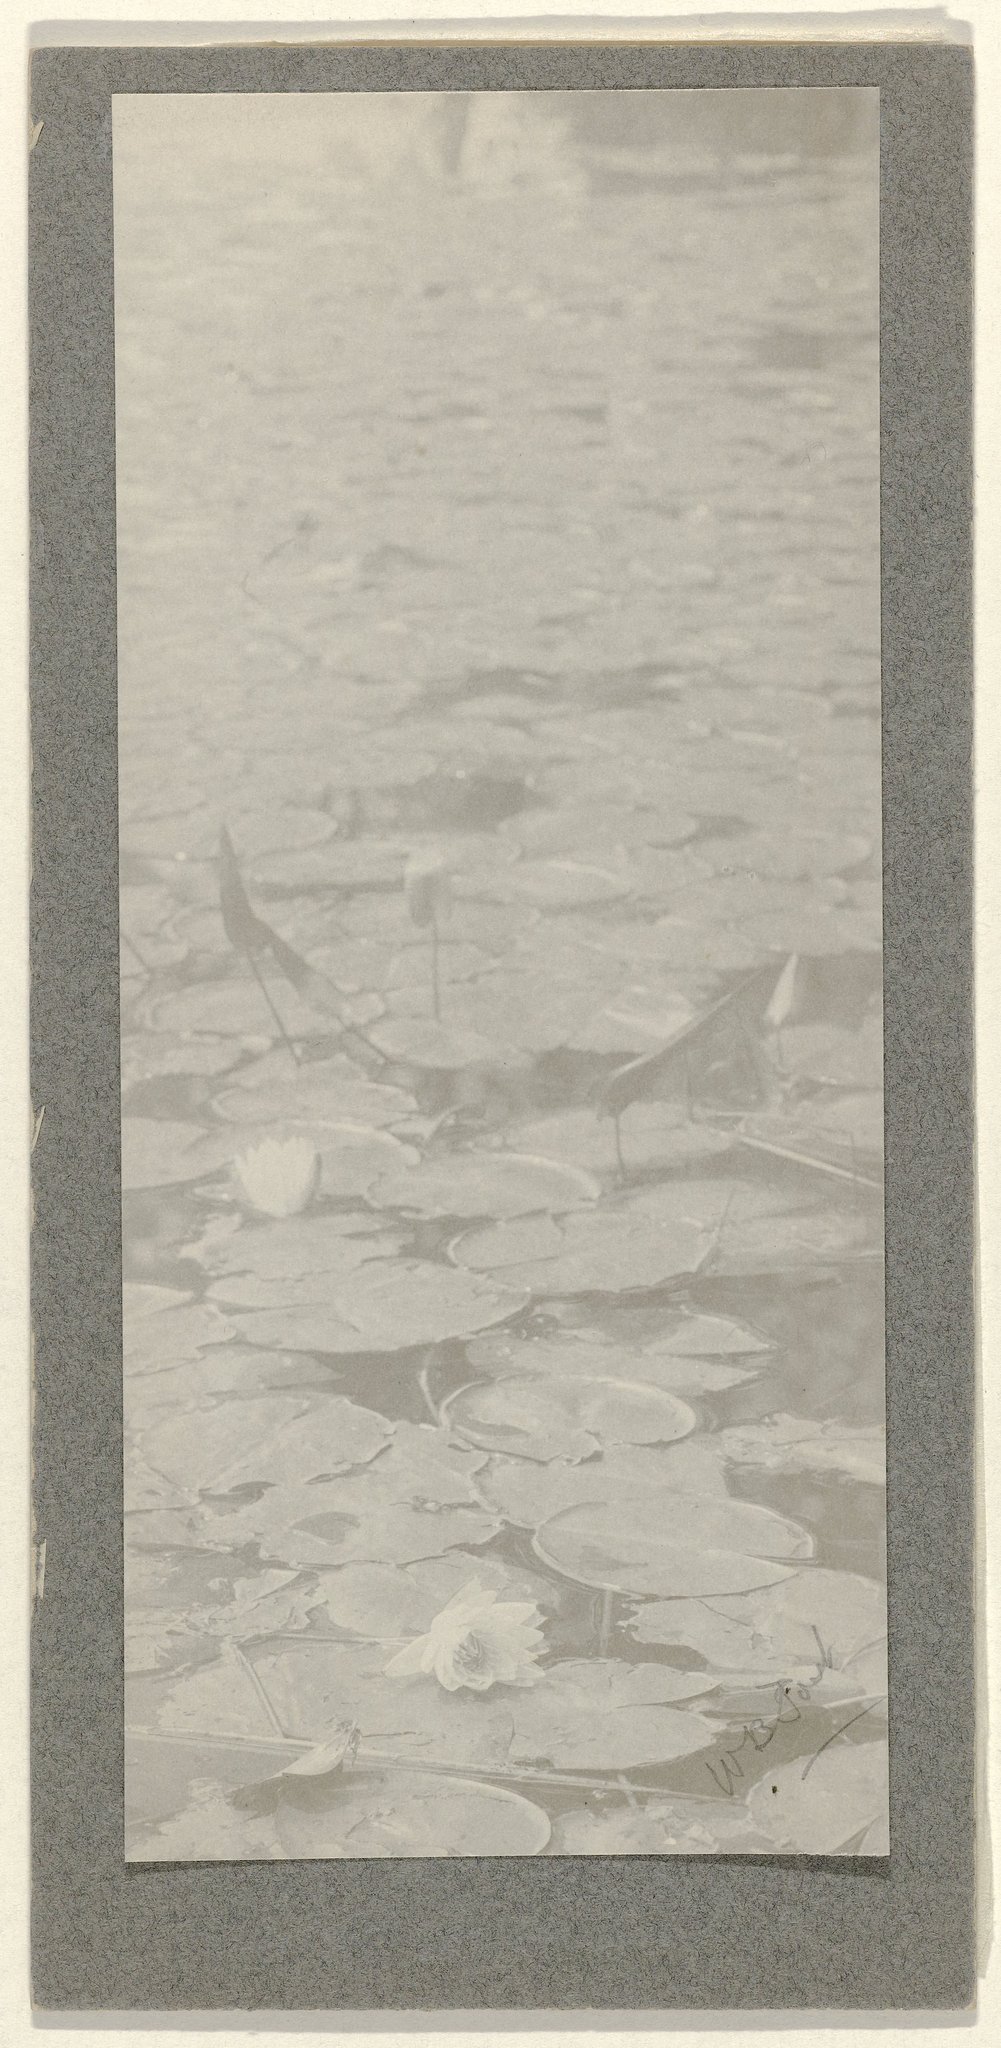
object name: photograph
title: Waterlelies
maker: william boyd post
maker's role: fotograaf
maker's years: 1857-1921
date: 1885-1915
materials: cardboard, photographic support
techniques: platinum process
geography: maine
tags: flowers: water-lily